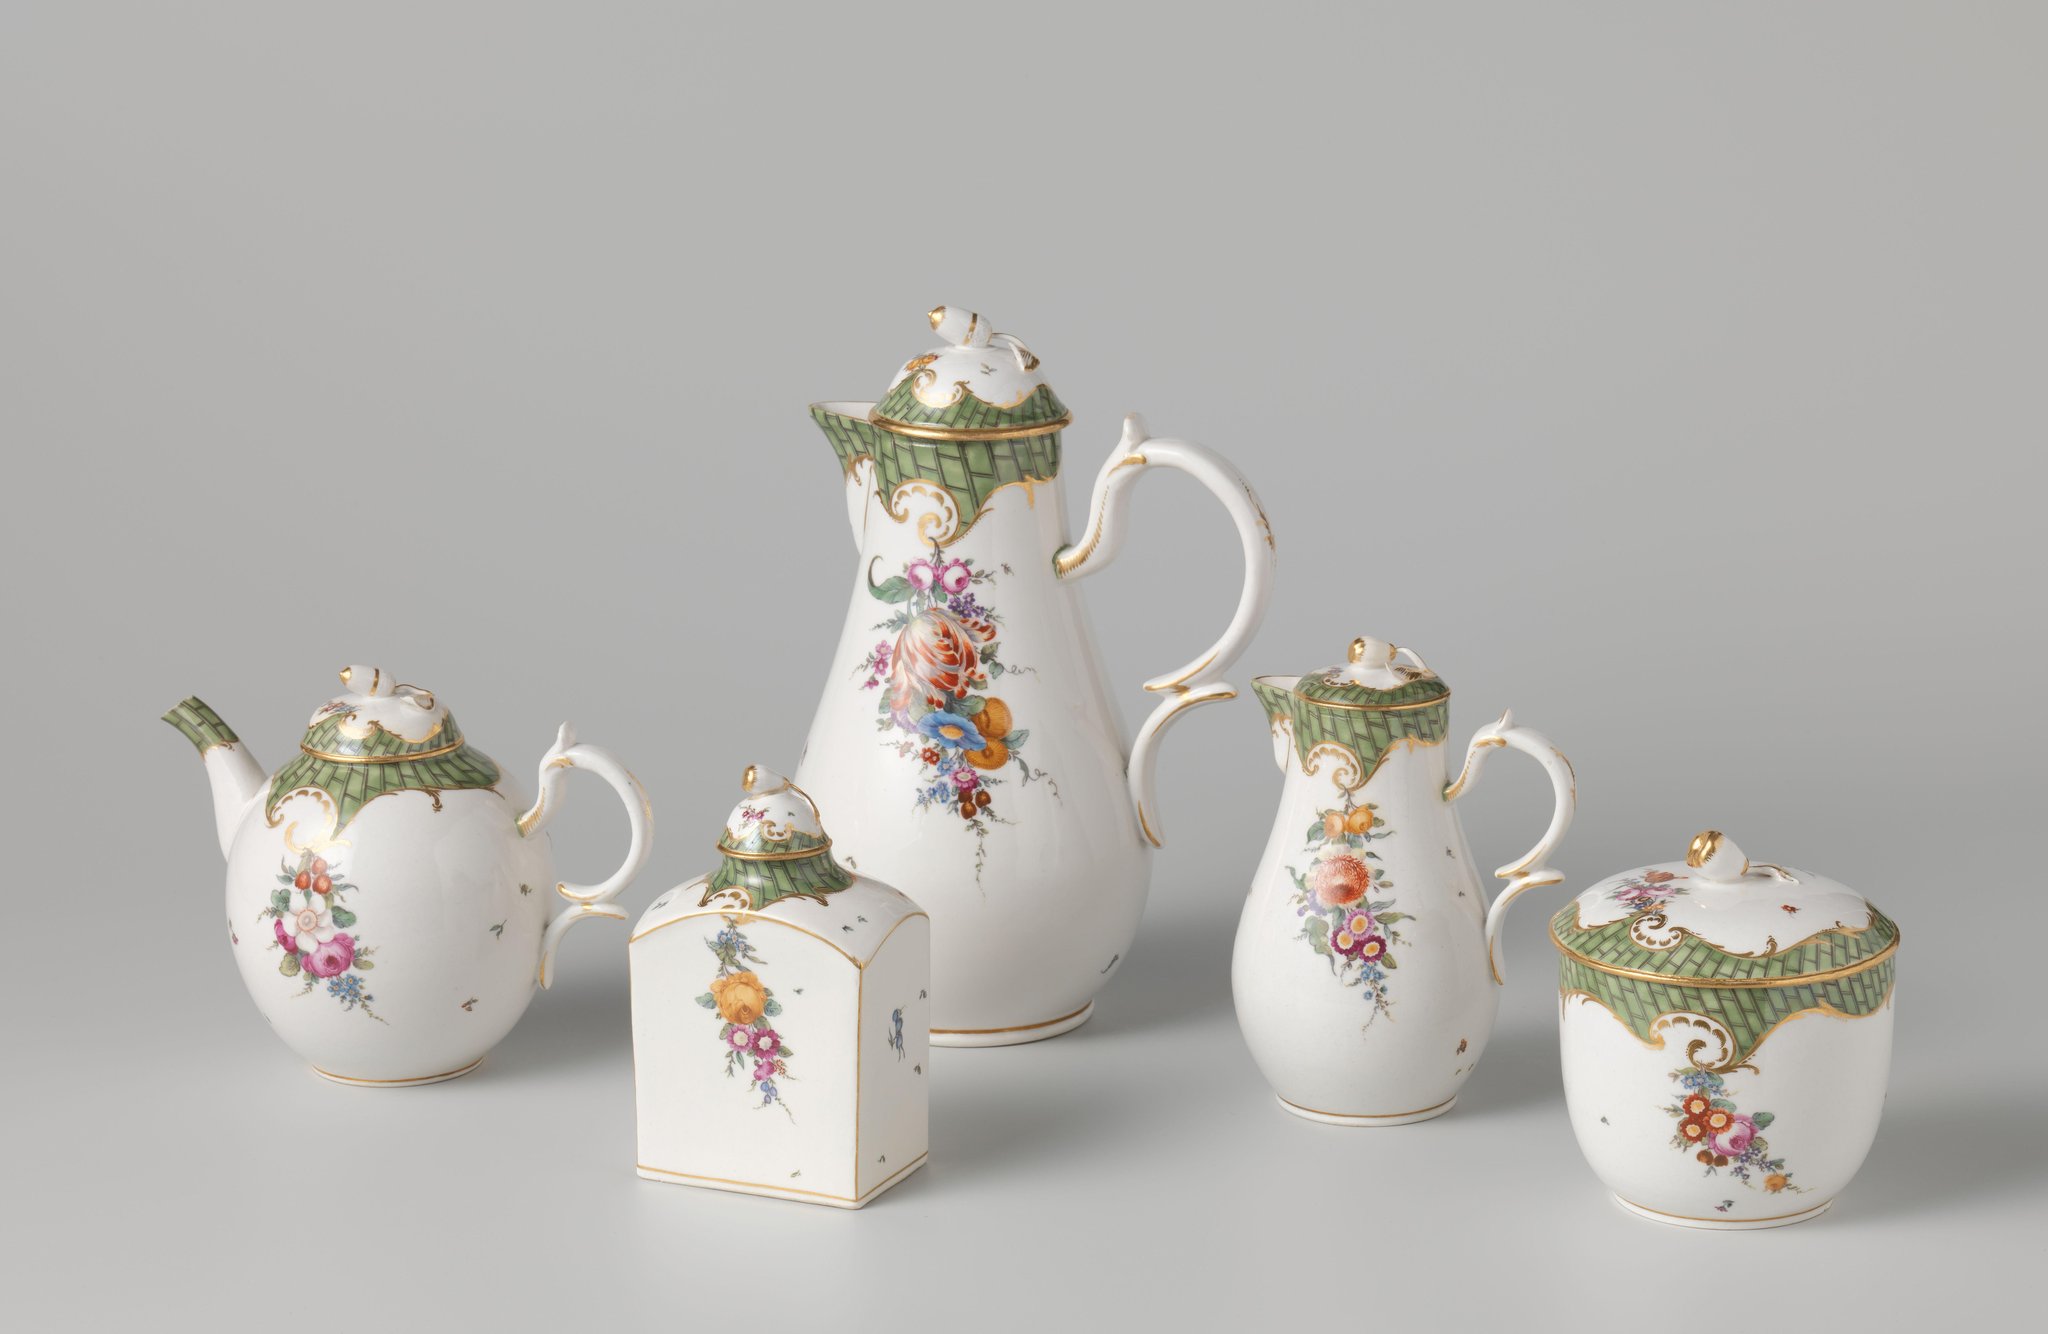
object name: coffee service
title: Coffee and tea service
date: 1775-1778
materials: porcelain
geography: loosdrecht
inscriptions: factory mark: ‘M:OL’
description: By attracting skilled artists and artisans, it was not long before Reverend De Mol was able to produce high-quality porcelain in the Loosdrecht factory. This beautiful service measures up to the wares that were made in most German porcelain factories from around 1760 onwards.